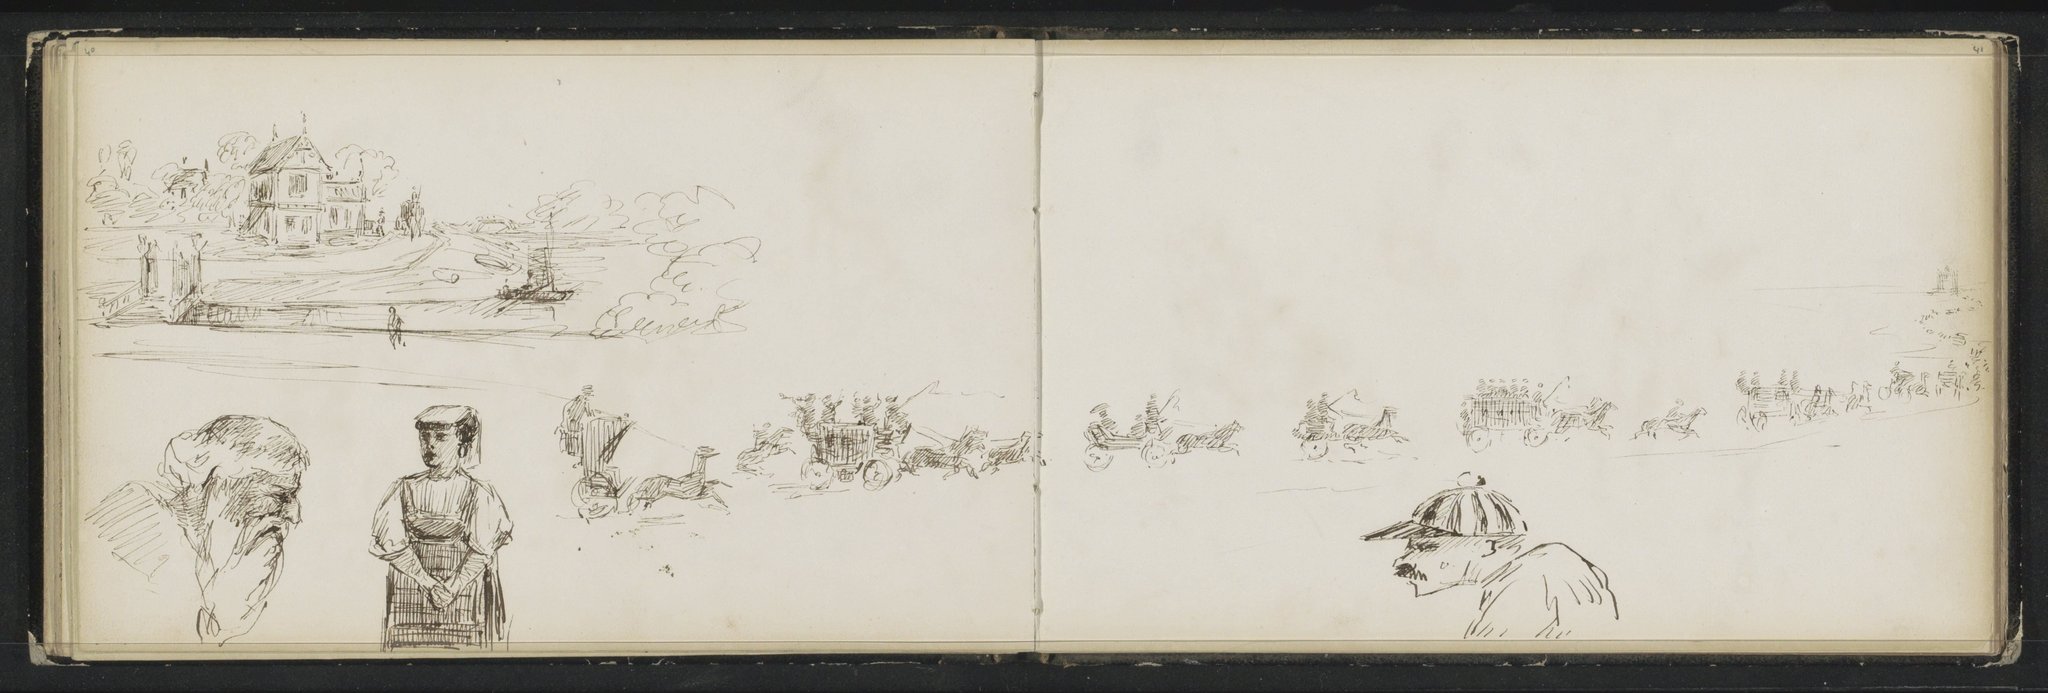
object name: sketchbook leaf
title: Studieblad, onder andere met een landgoed aan een rivier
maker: marius bauer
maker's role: draughtsman, print maker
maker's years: 1867-1932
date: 1812-1880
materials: paper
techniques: pen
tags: adult woman, river, adult man, four-wheeled, animal-drawn vehicle, e.g.: cab, carriage, coach, bridge, country-house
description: Tevens een studie van een optocht van paarden met figuren in koetsen en figuurstudies van een oude man, een man met pet en een vrouw. Pagina 40 en 41 uit een schetsboek met 34 bladen.